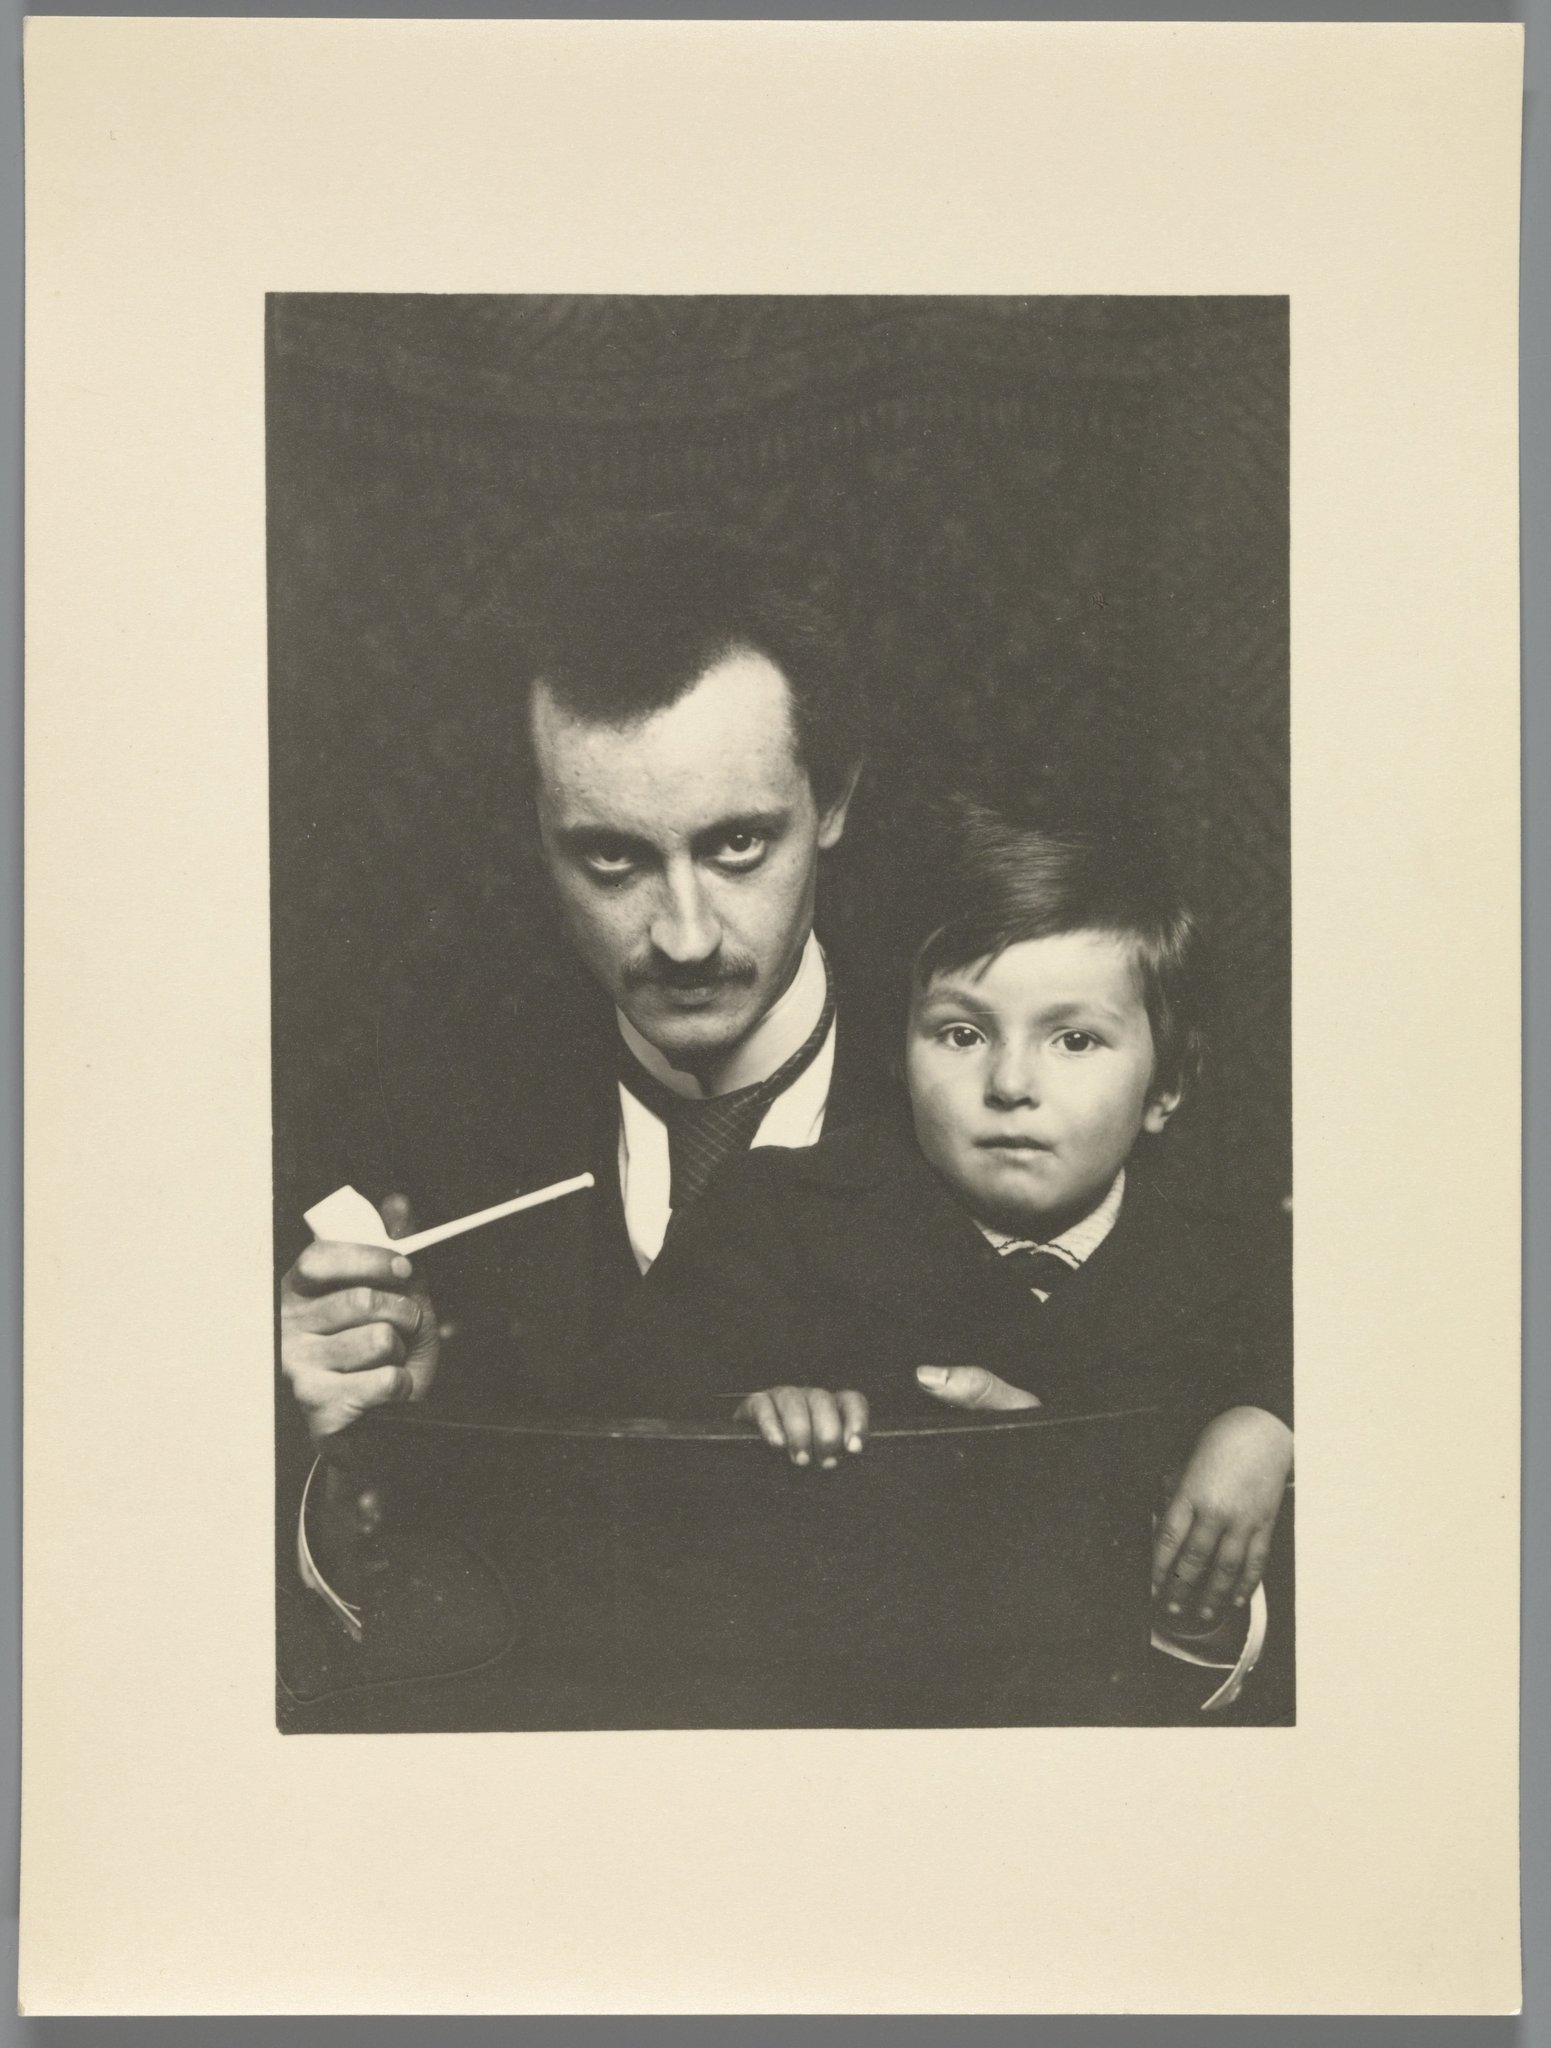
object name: photograph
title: Reproductie naar een foto van Willem Witsen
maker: Anonymous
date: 1860-1915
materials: paper, photographic support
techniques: gelatin silver print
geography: netherlands